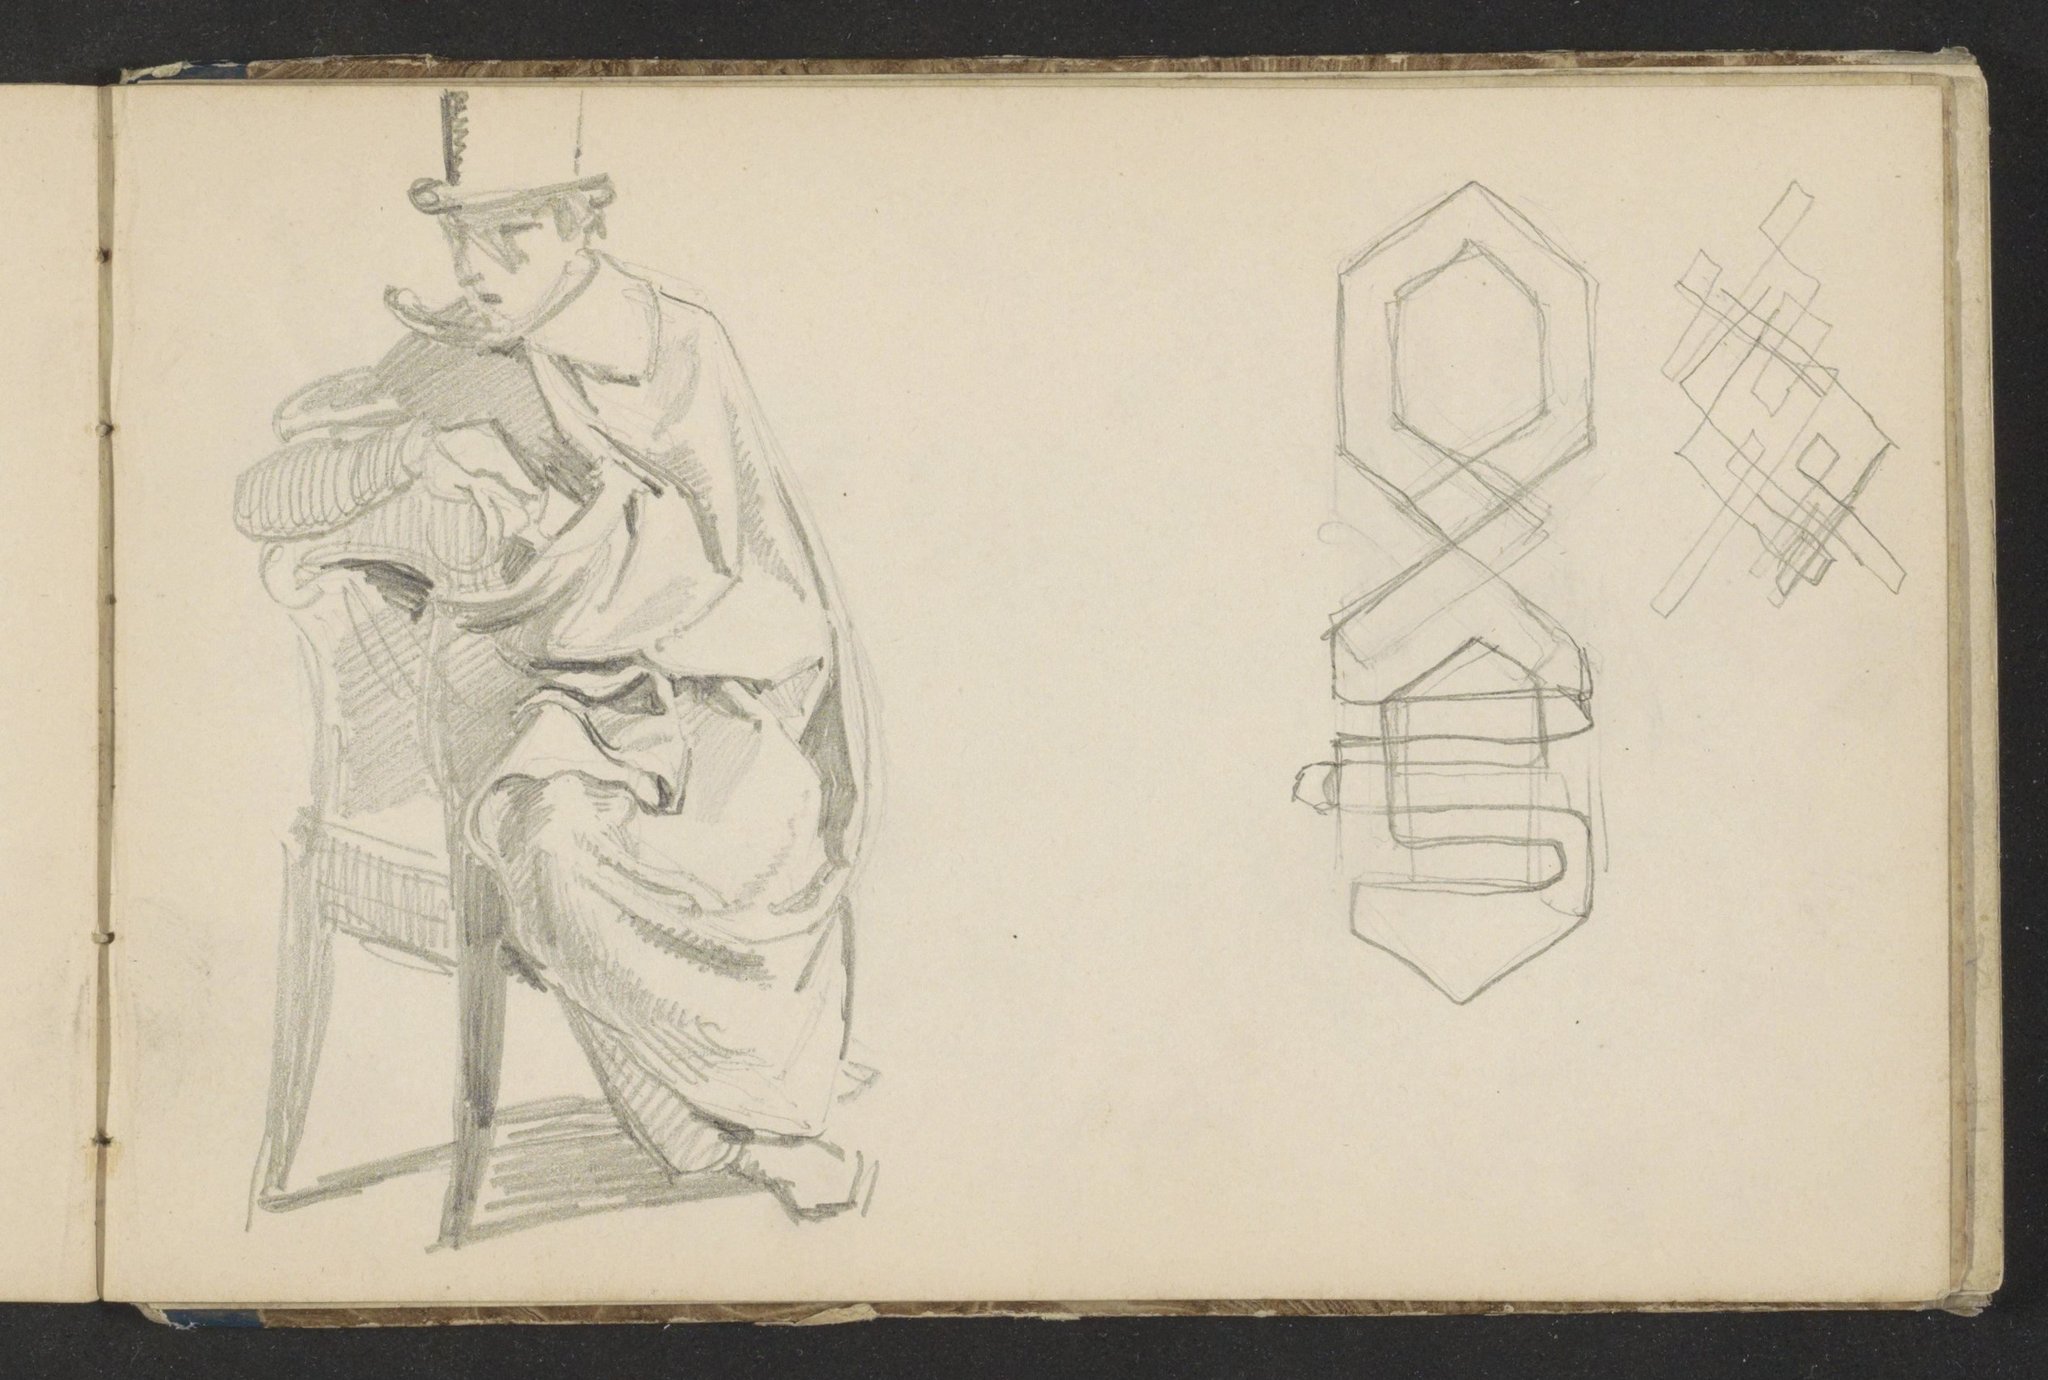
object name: sketchbook leaf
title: Man zittend op een stoel en ornamenten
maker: Anonymous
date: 1841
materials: paper, pencil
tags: ornaments ~ art, sitting figure, coat, cape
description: De man draagt een mantel en een hoge hoed. Blad 20 recto uit een schetsboek met 33 bladen.